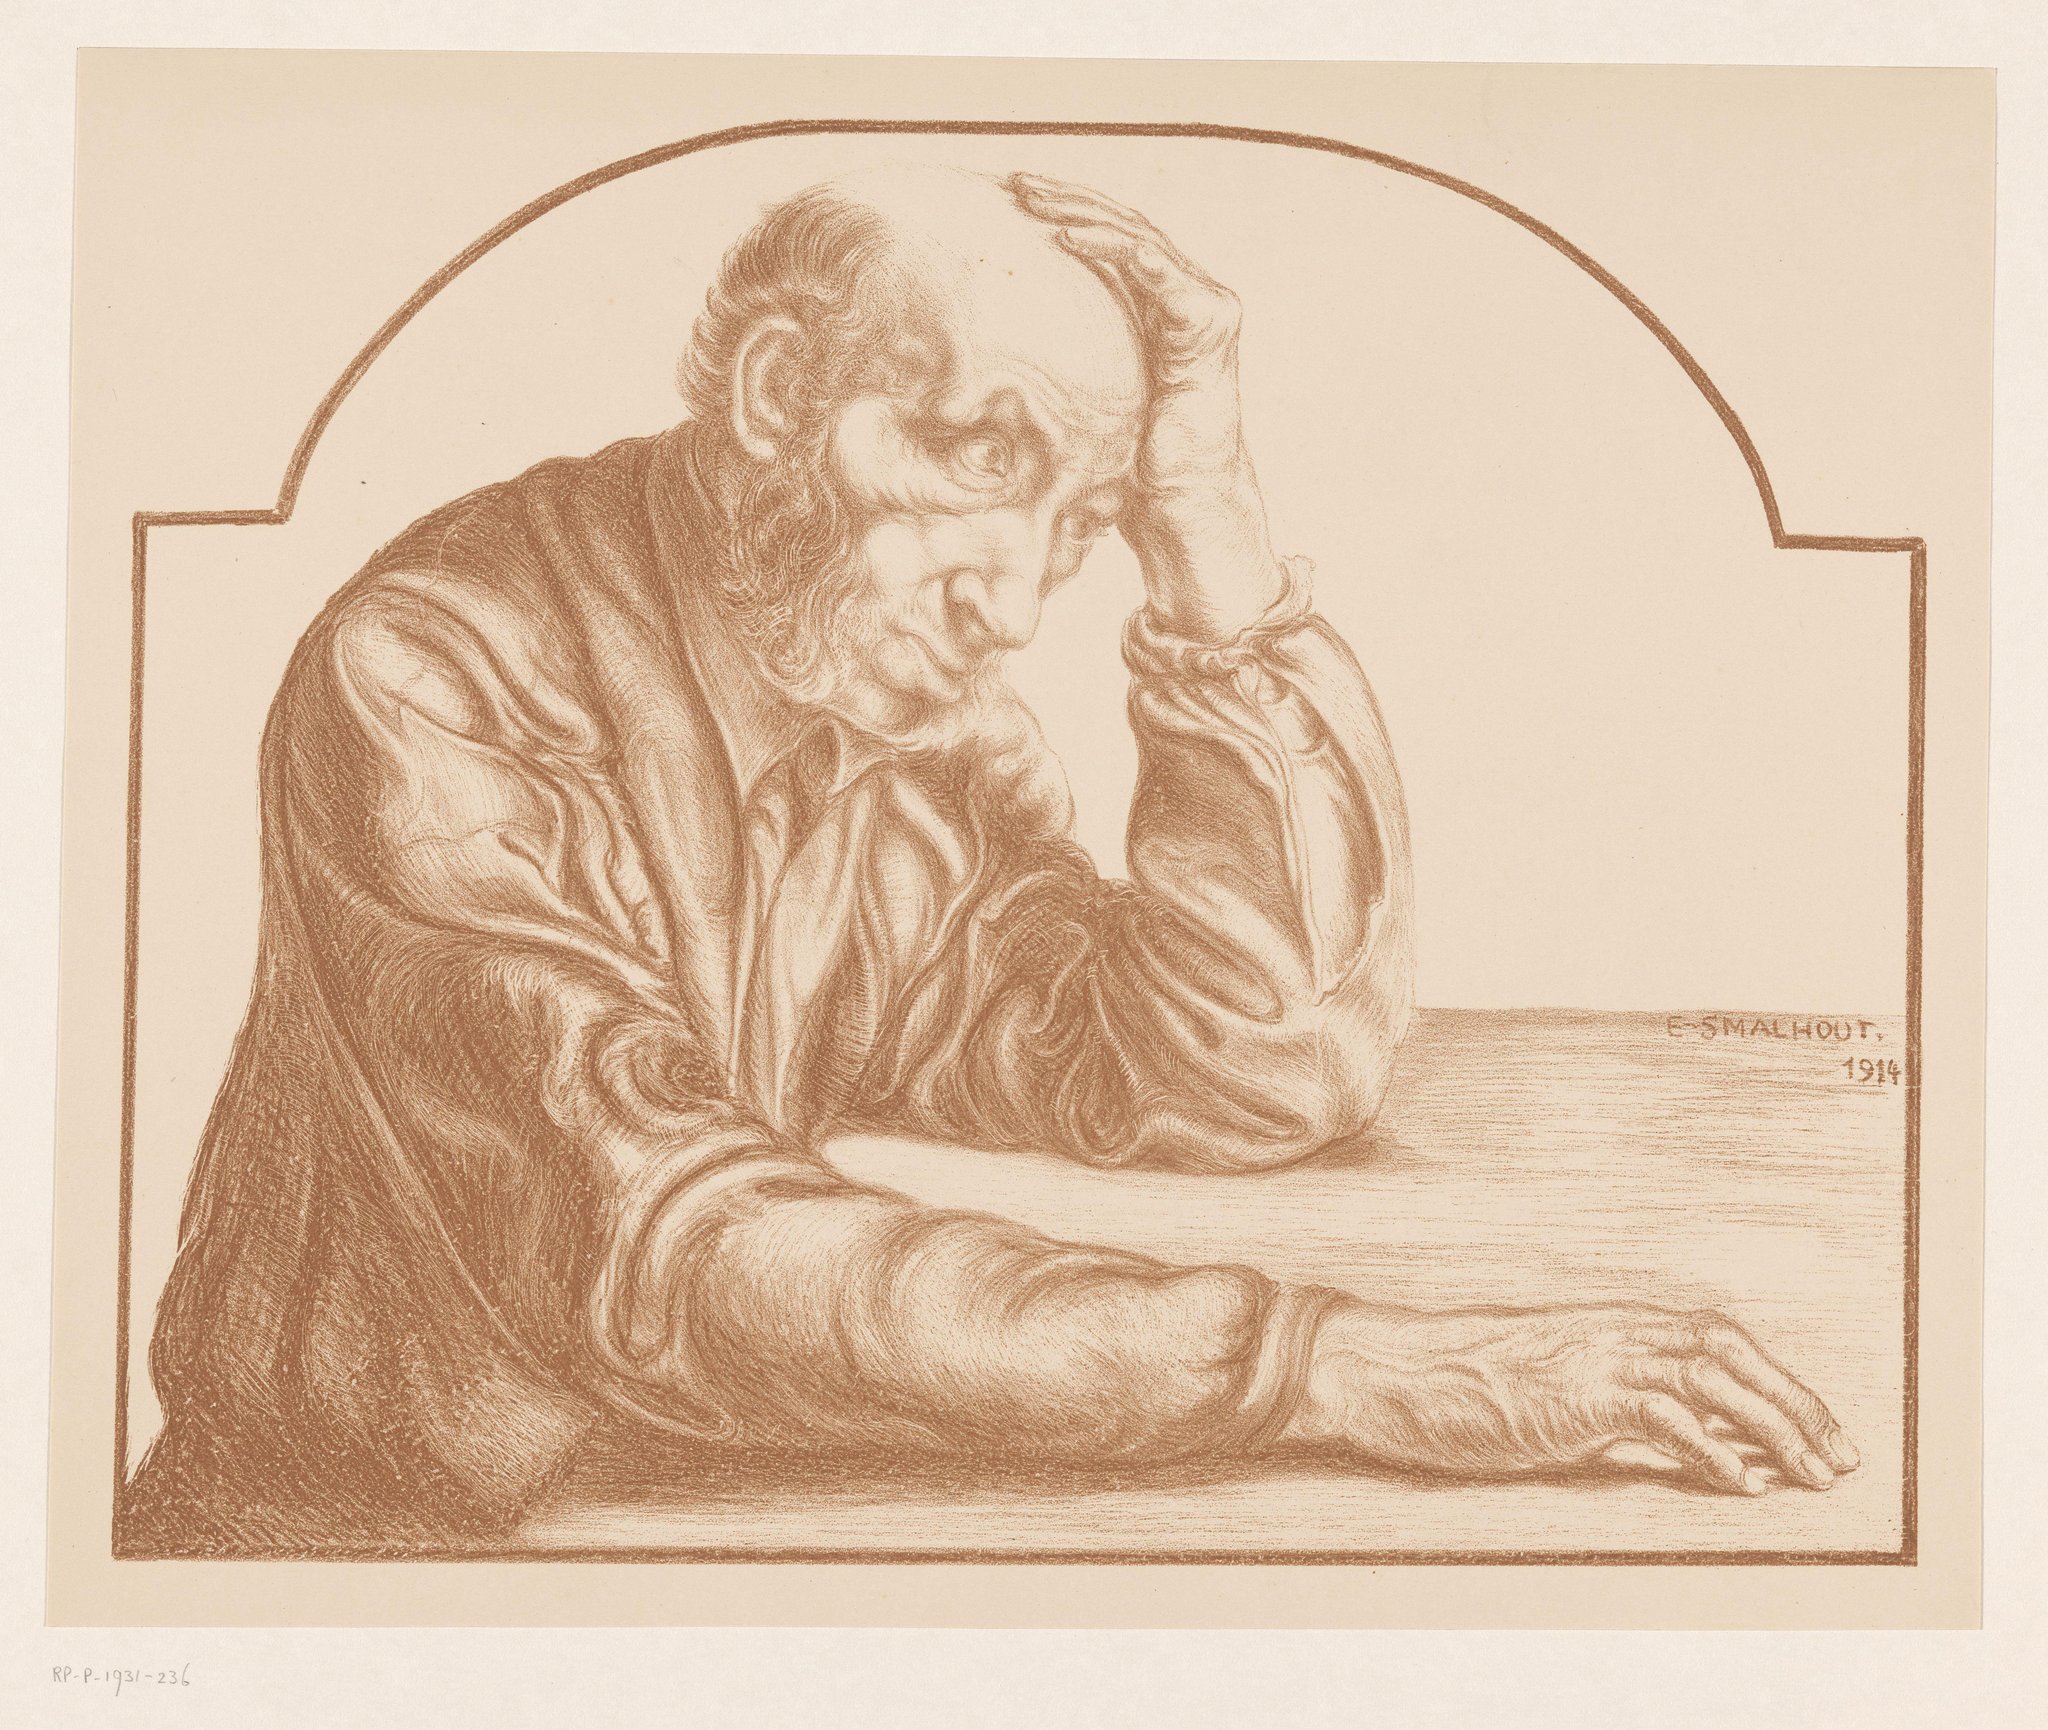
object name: print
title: Oude man aan tafel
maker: elias smalhout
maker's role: print maker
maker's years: 1889-1939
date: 1914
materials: paper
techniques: lithograph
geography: netherlands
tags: morphology of human expression (+ thinking, meditating), old man (+ three-quarter view)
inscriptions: collector's mark: Lugt 2228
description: Een oude man zit aan tafel. Zijn rechterarm ligt uitgestrekt op tafel en met zijn linkerhand ondersteunt hij zijn hoofd.